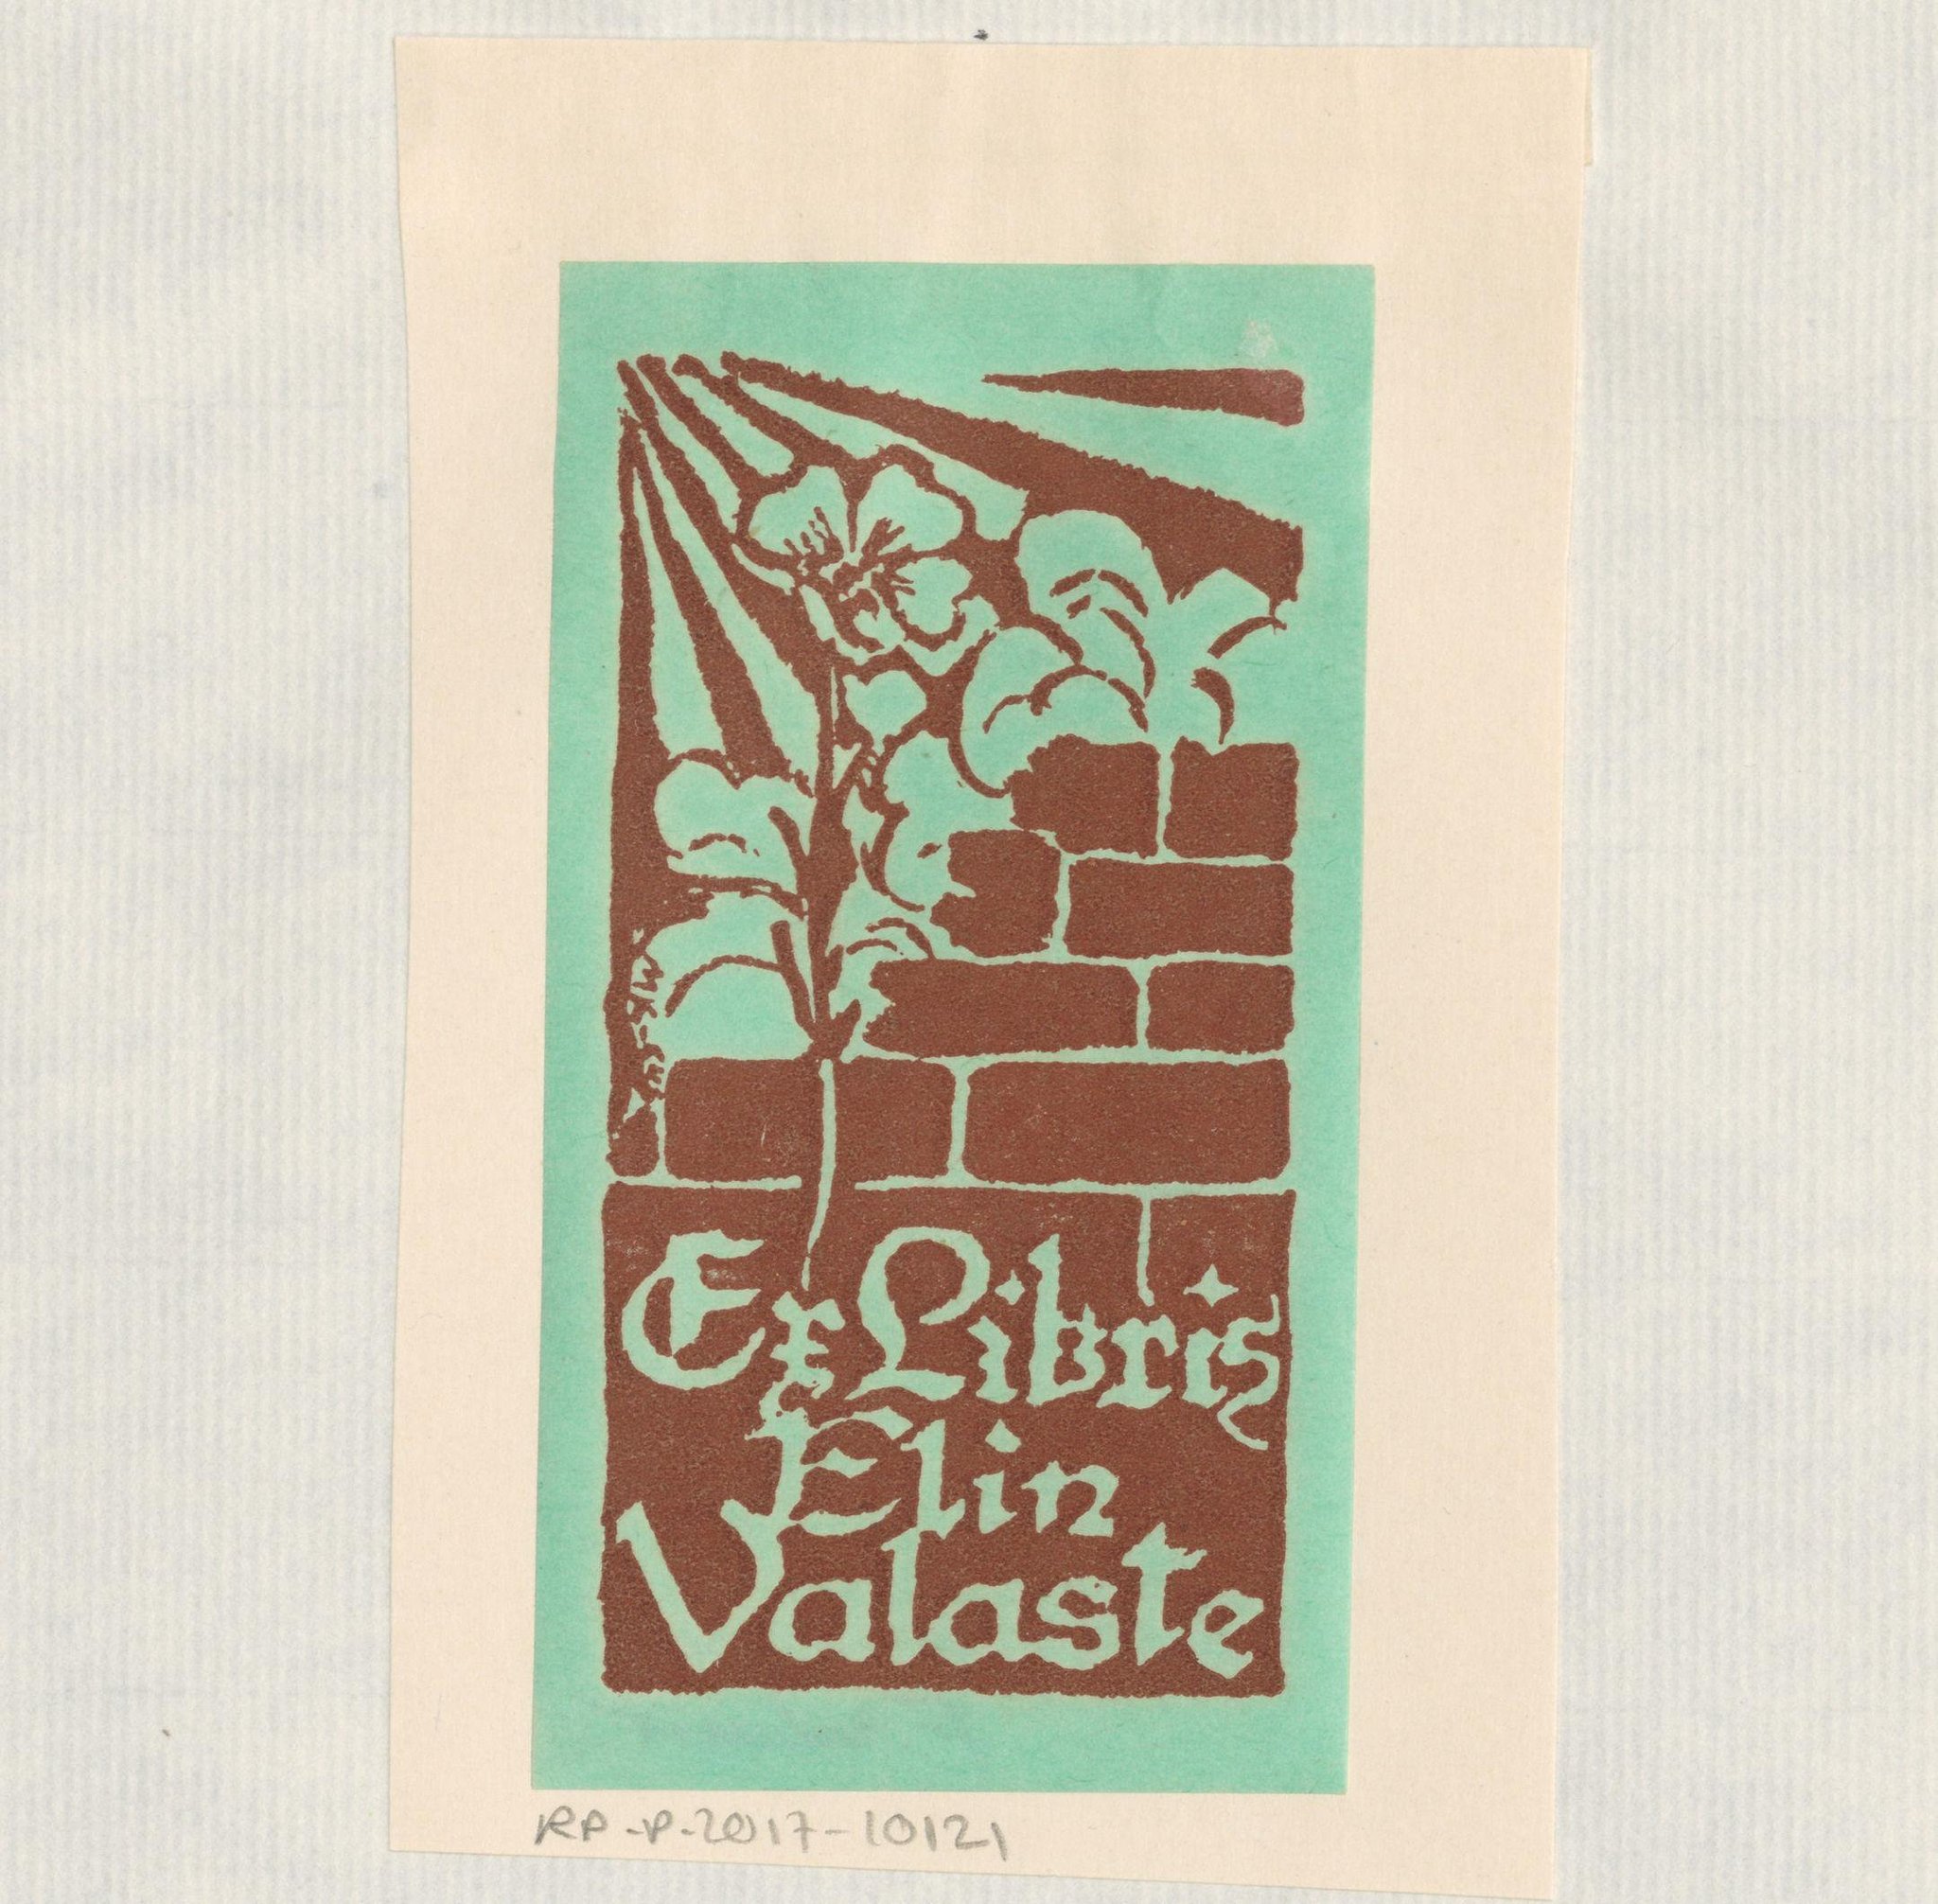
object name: bookplate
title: Ex libris van Elin Valaste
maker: pekka törmä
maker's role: print maker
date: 1930-1959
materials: paper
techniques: linocut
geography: finland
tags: flowers, brick works